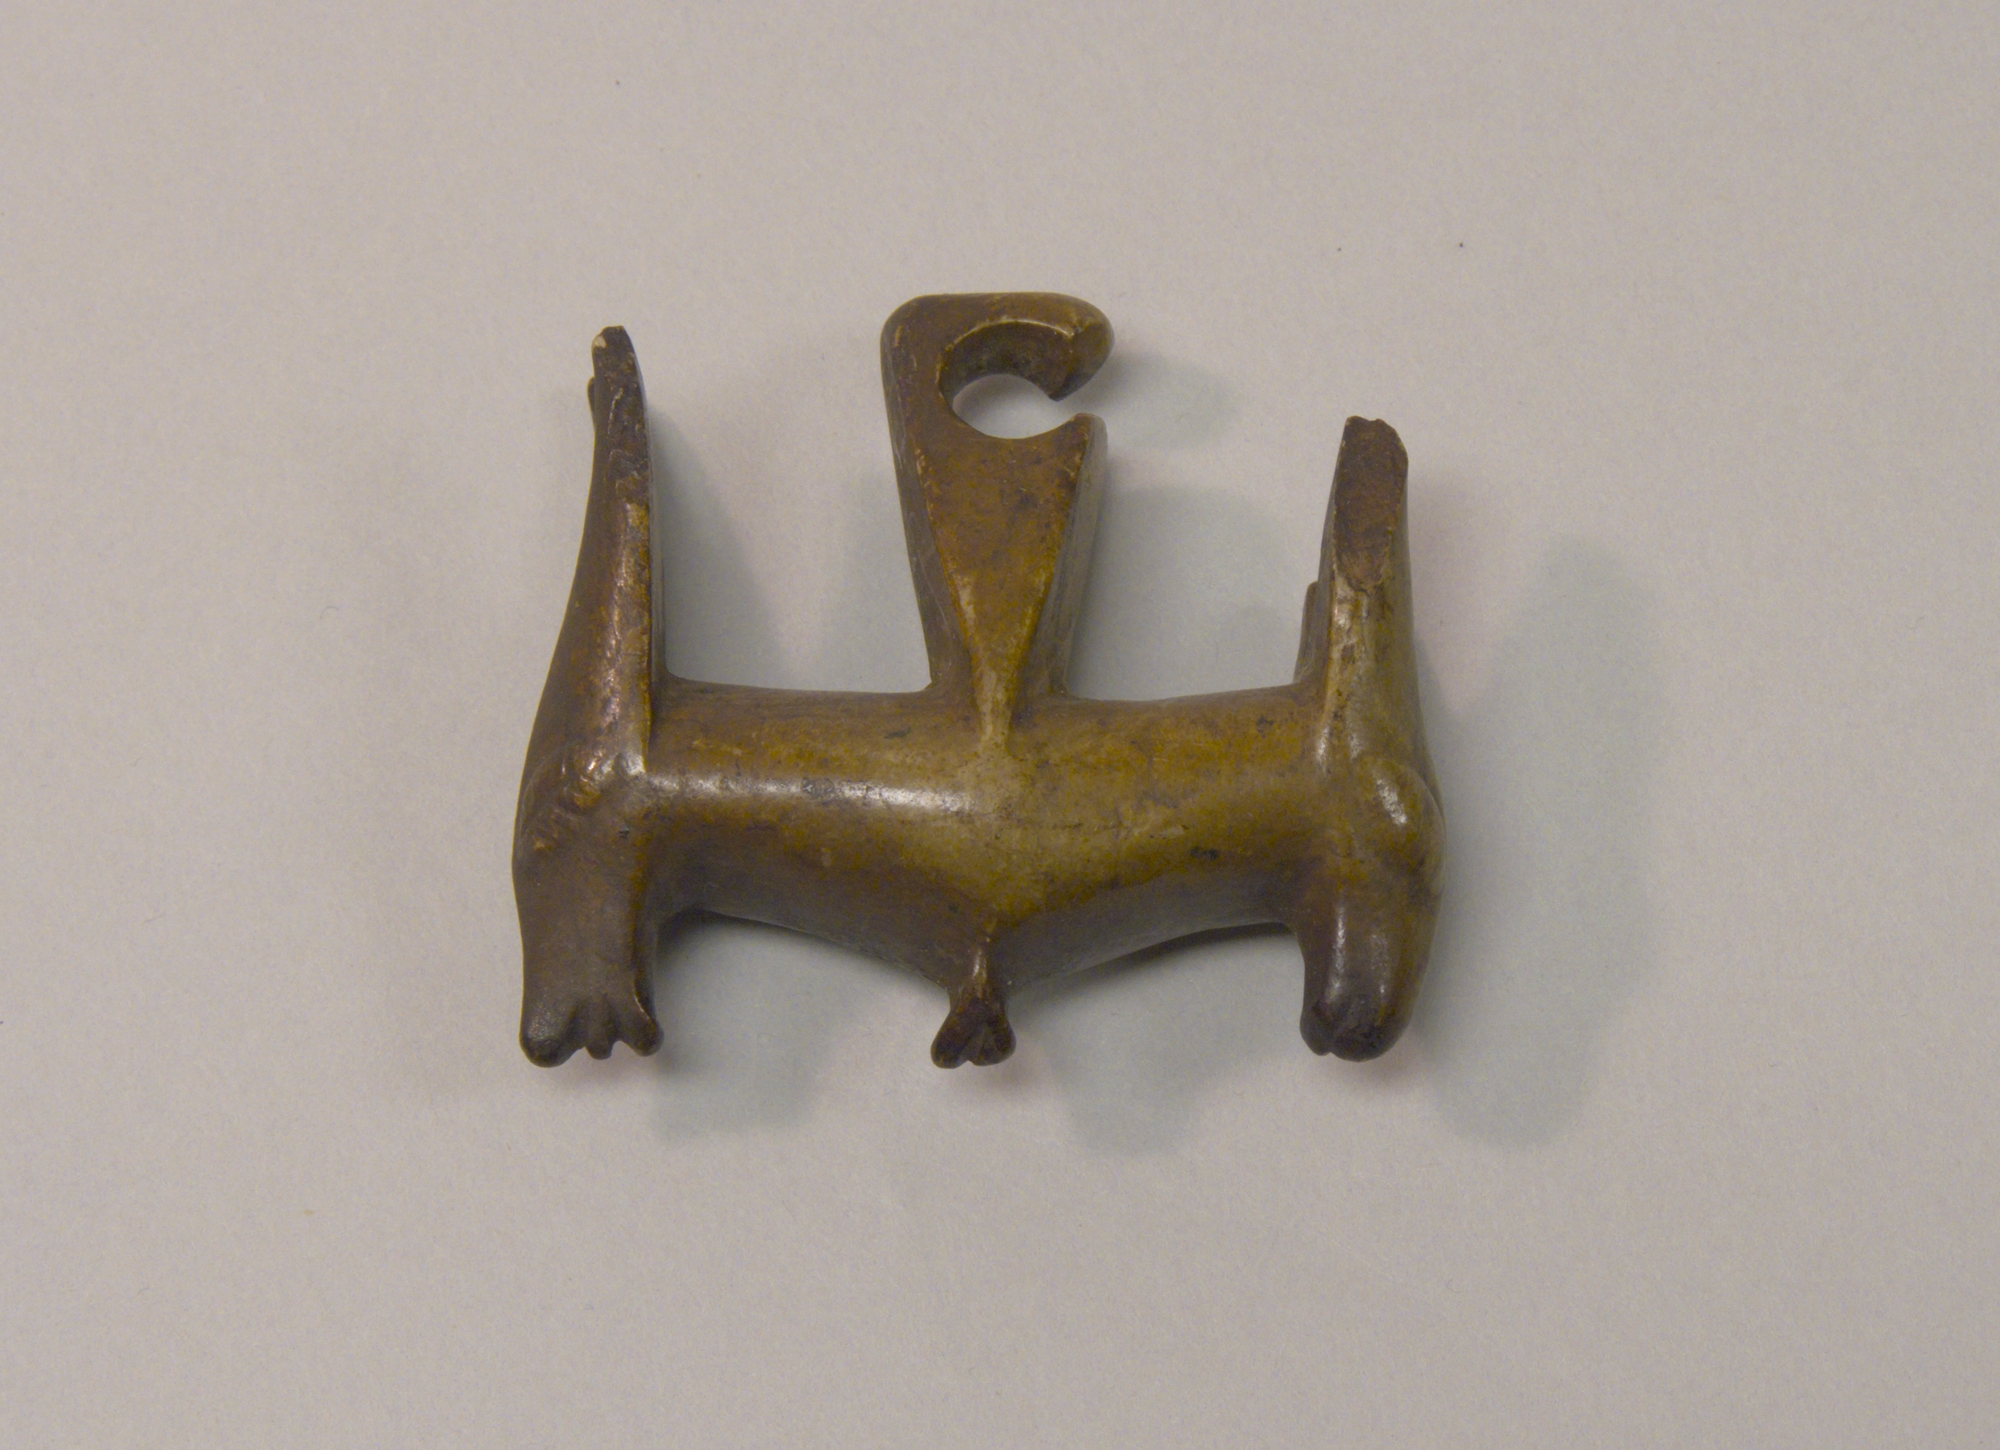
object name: earring with pendant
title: Ear pendant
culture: vietnamese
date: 500 BCE-300 CE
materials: stone